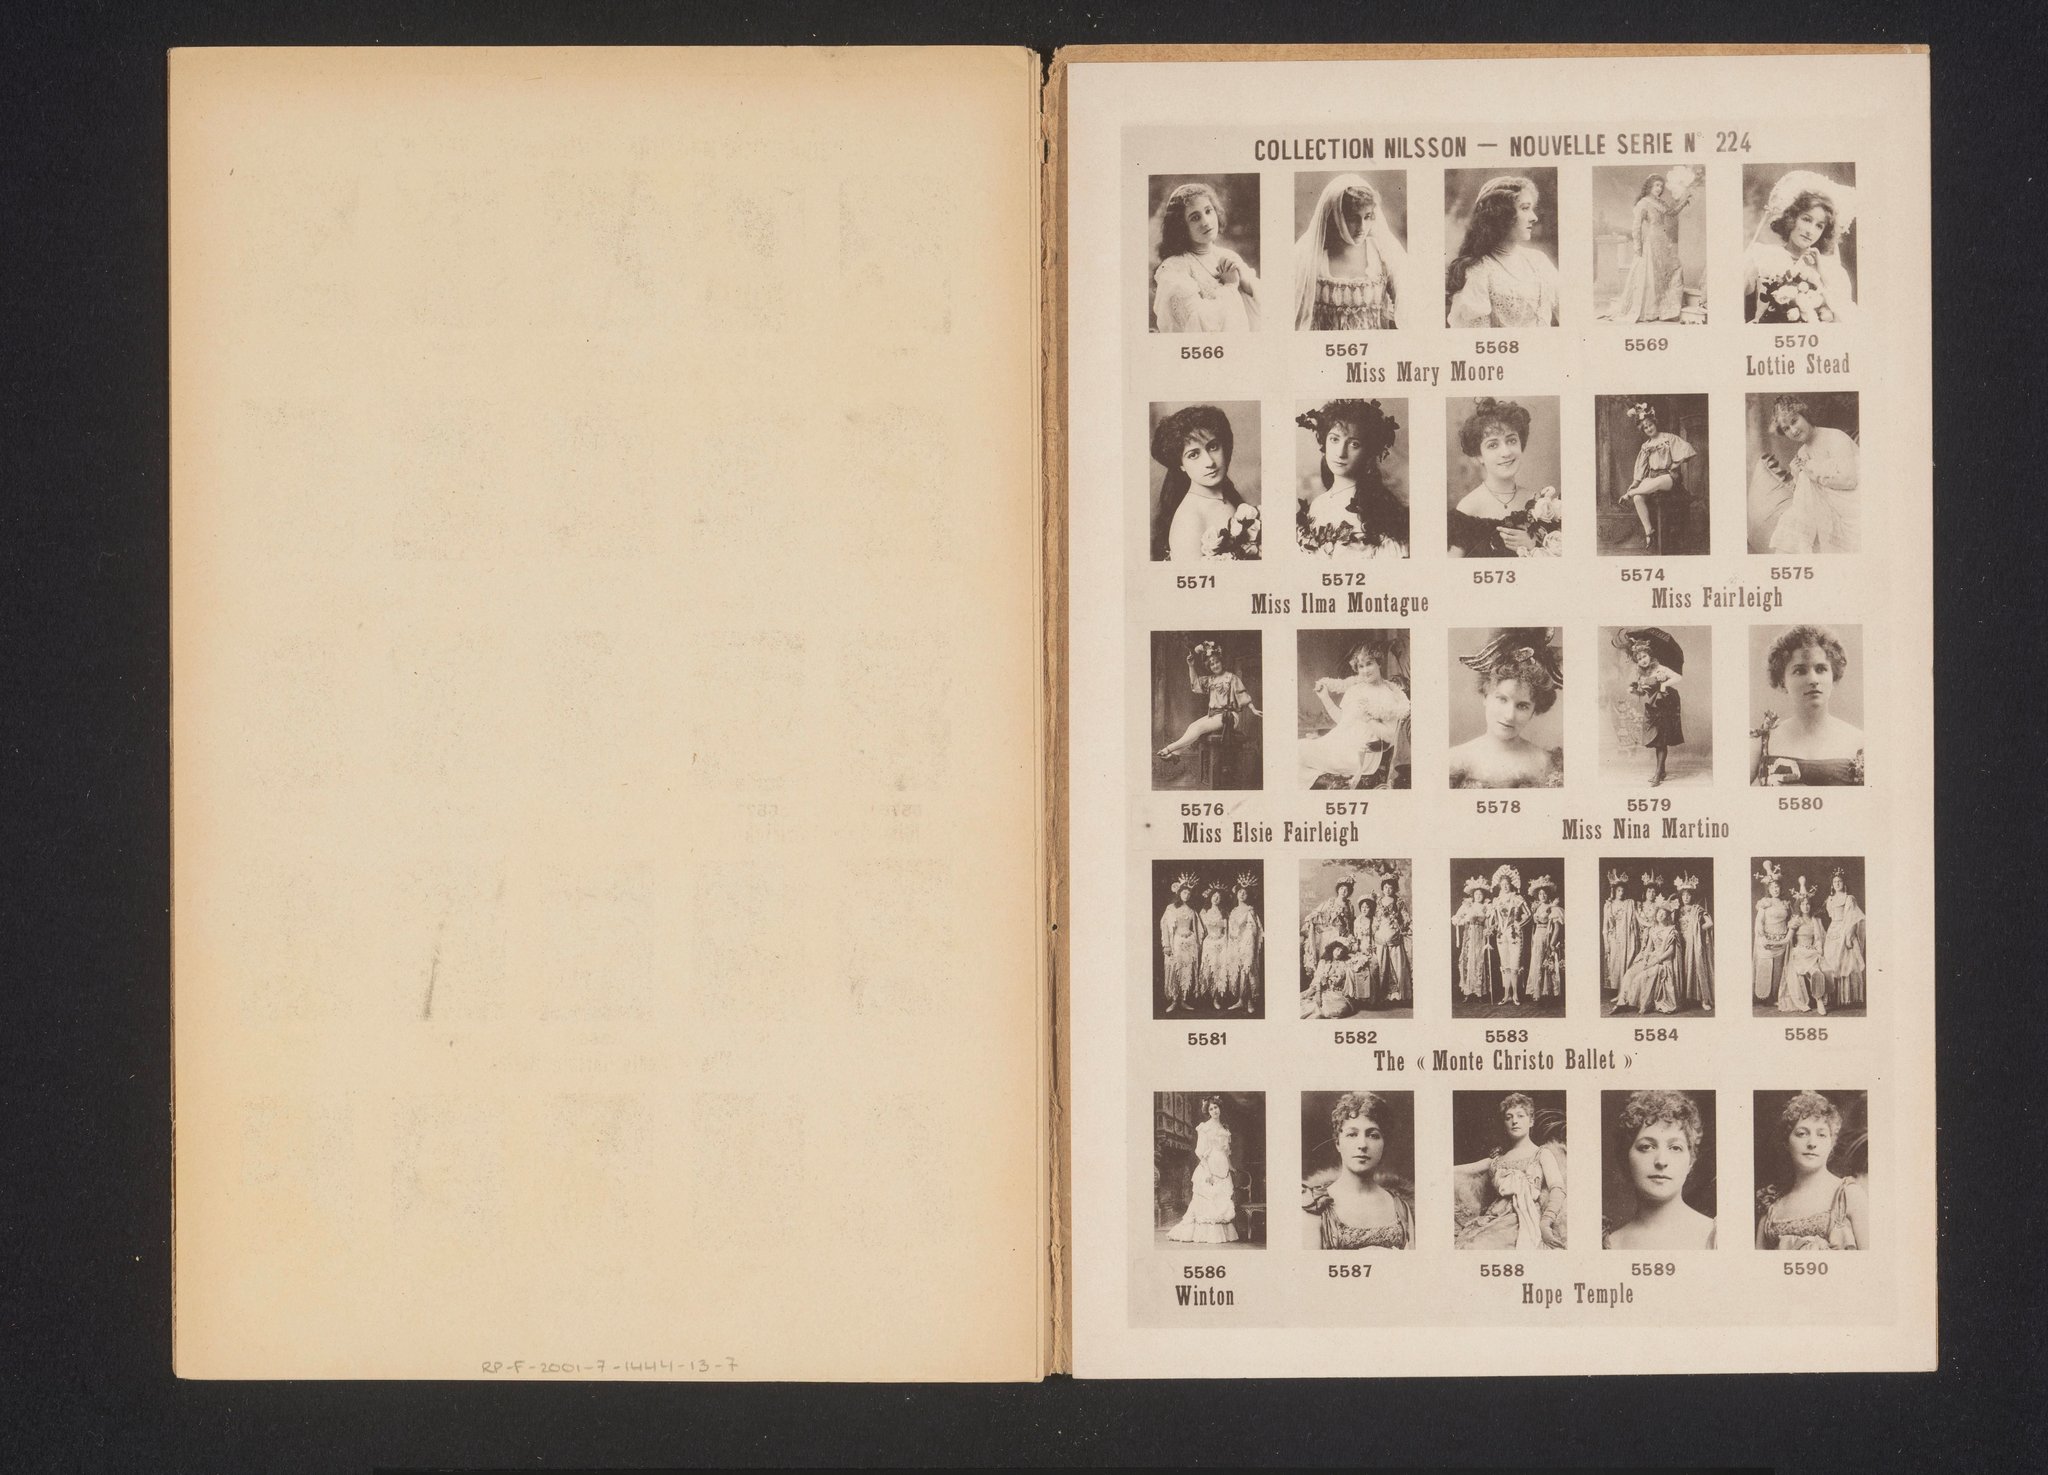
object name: page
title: Collection Nilsson - Nouvelle Série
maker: Anonymous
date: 1894-1899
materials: paper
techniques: photograph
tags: historical persons - bb - woman, portrait of composer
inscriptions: inscription: ‘Miss Mary Moore Lottie Stead/ Miss Ilma Montague Miss Fairleigh/ Miss Elsie Fairleigh Miss Nina Martino/ The < < Monte Christo Ballet > >/ Winton Hope Temple’, number: ‘No 224’